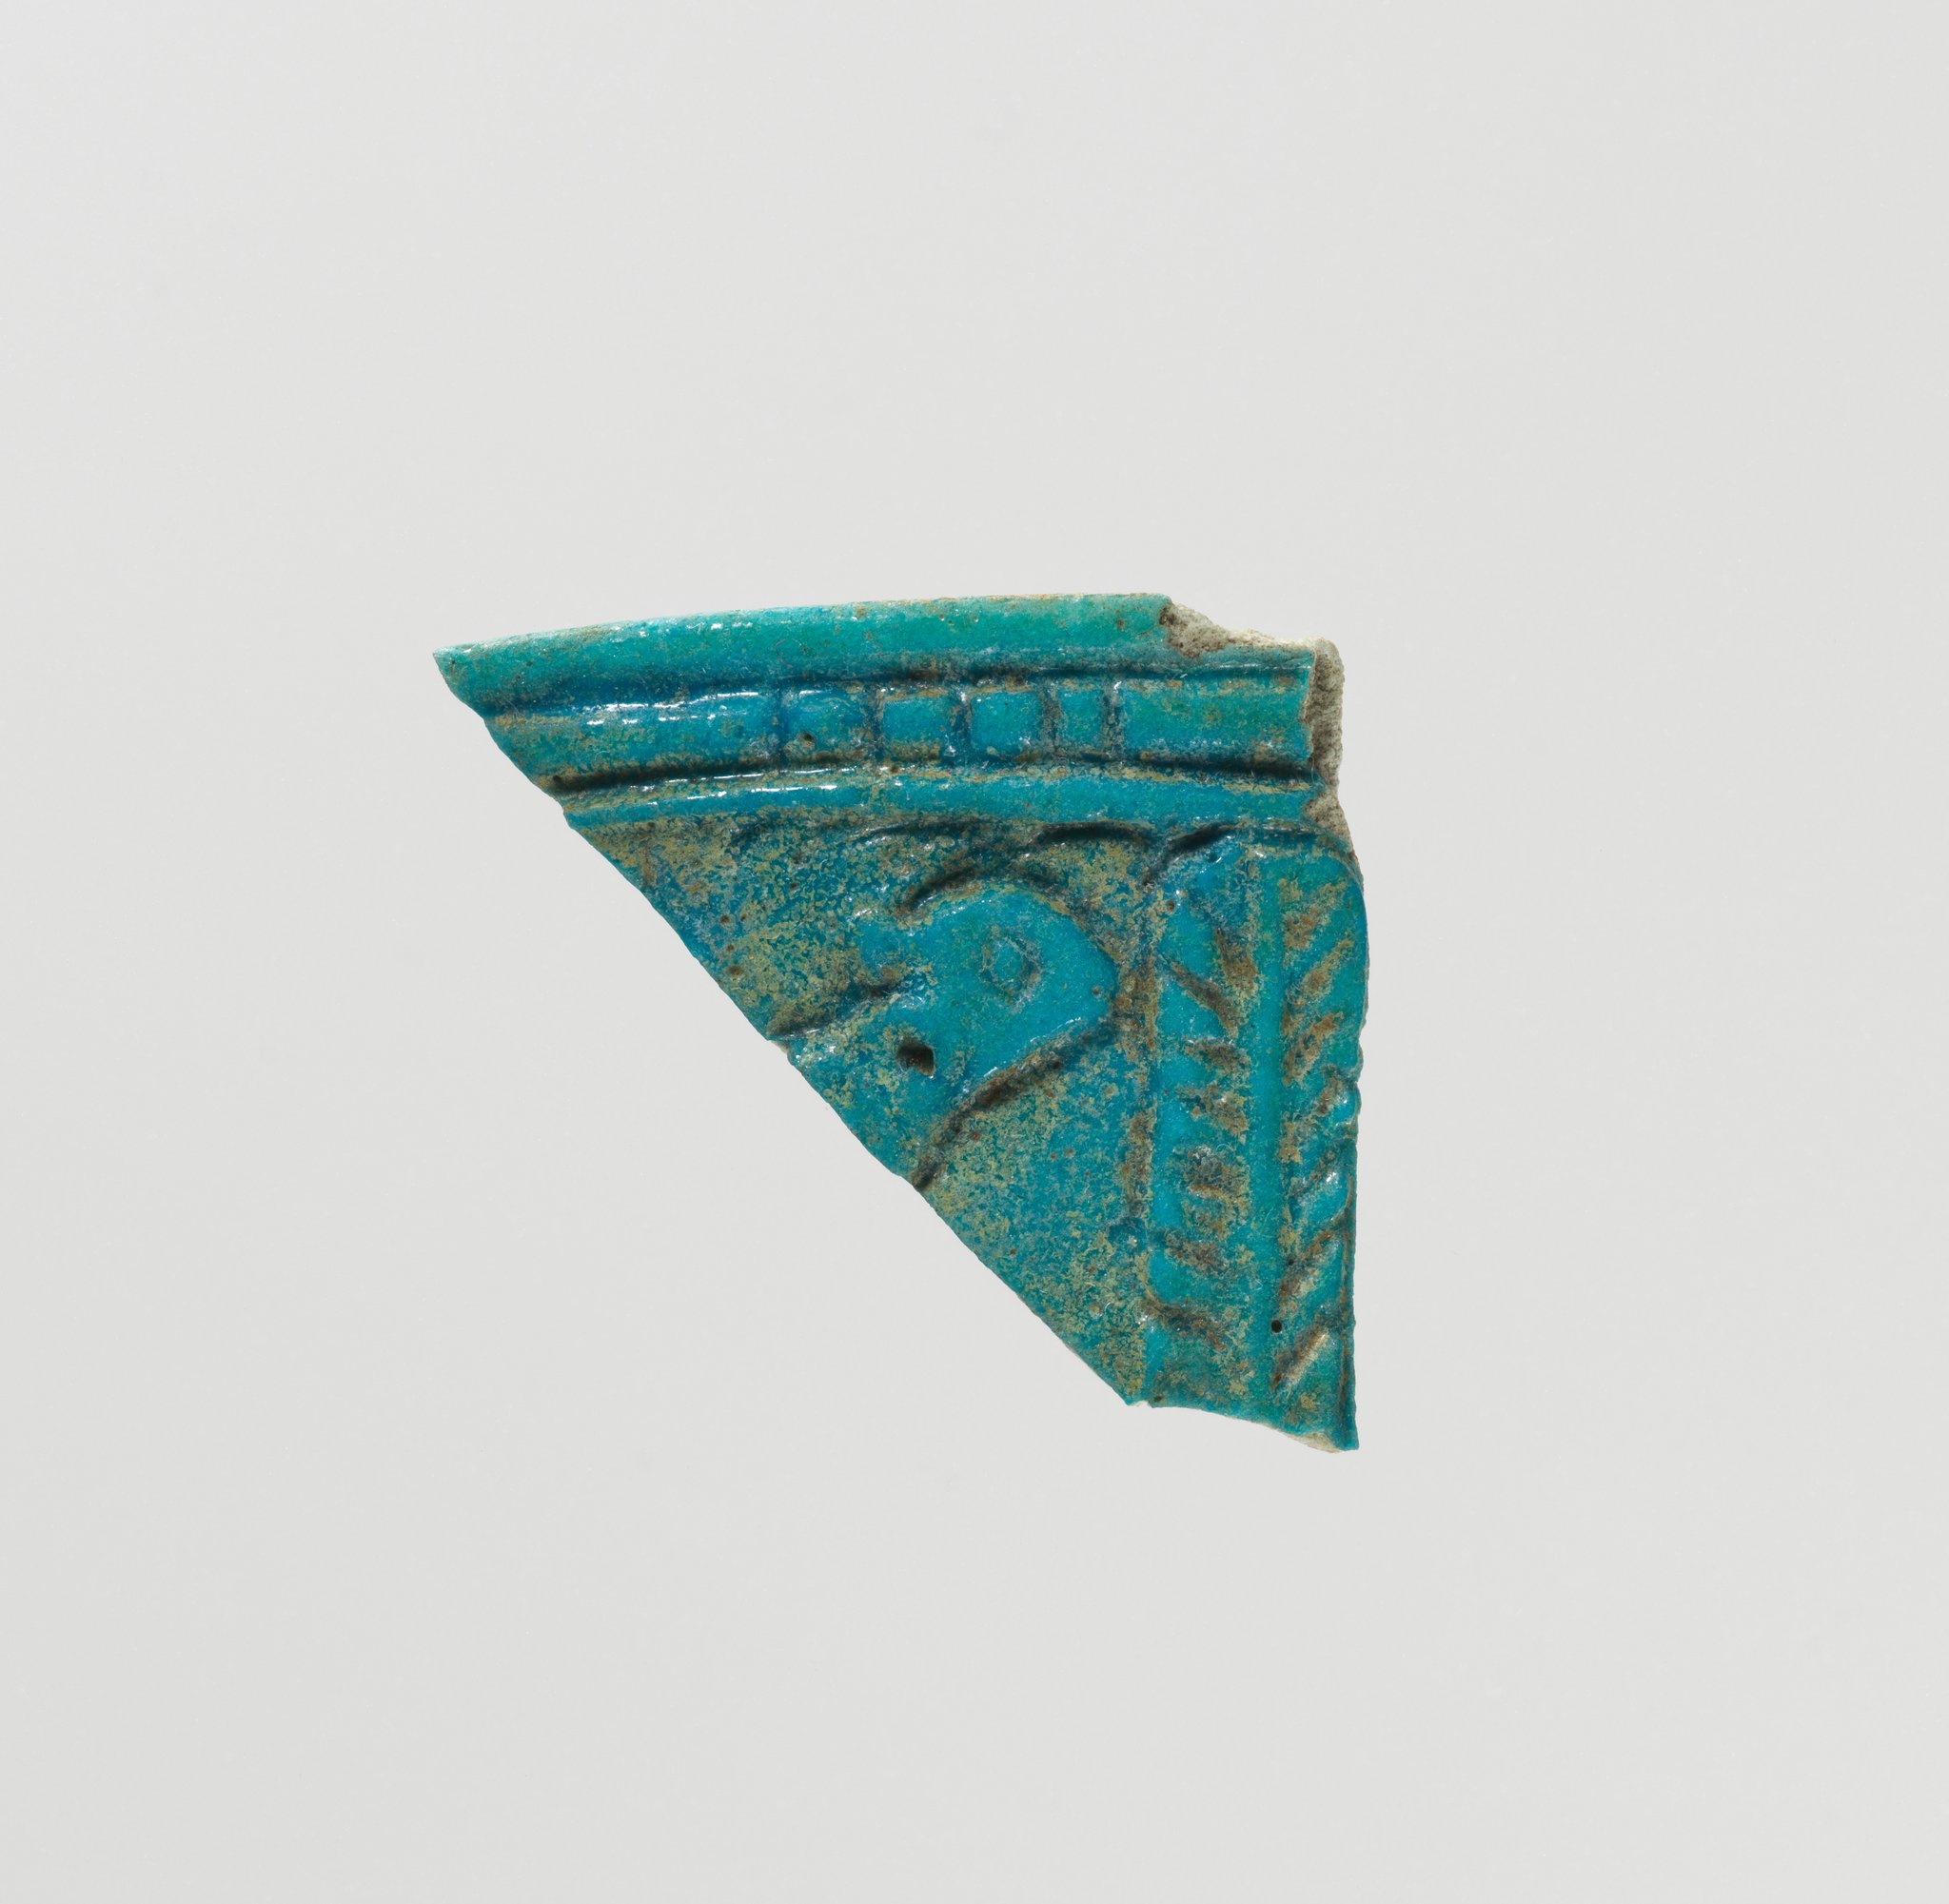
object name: chalice, cup, lotiform, relief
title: Rim fragment with head of calf and "stylized trees"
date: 1070-664 BCE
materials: faience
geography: egypt